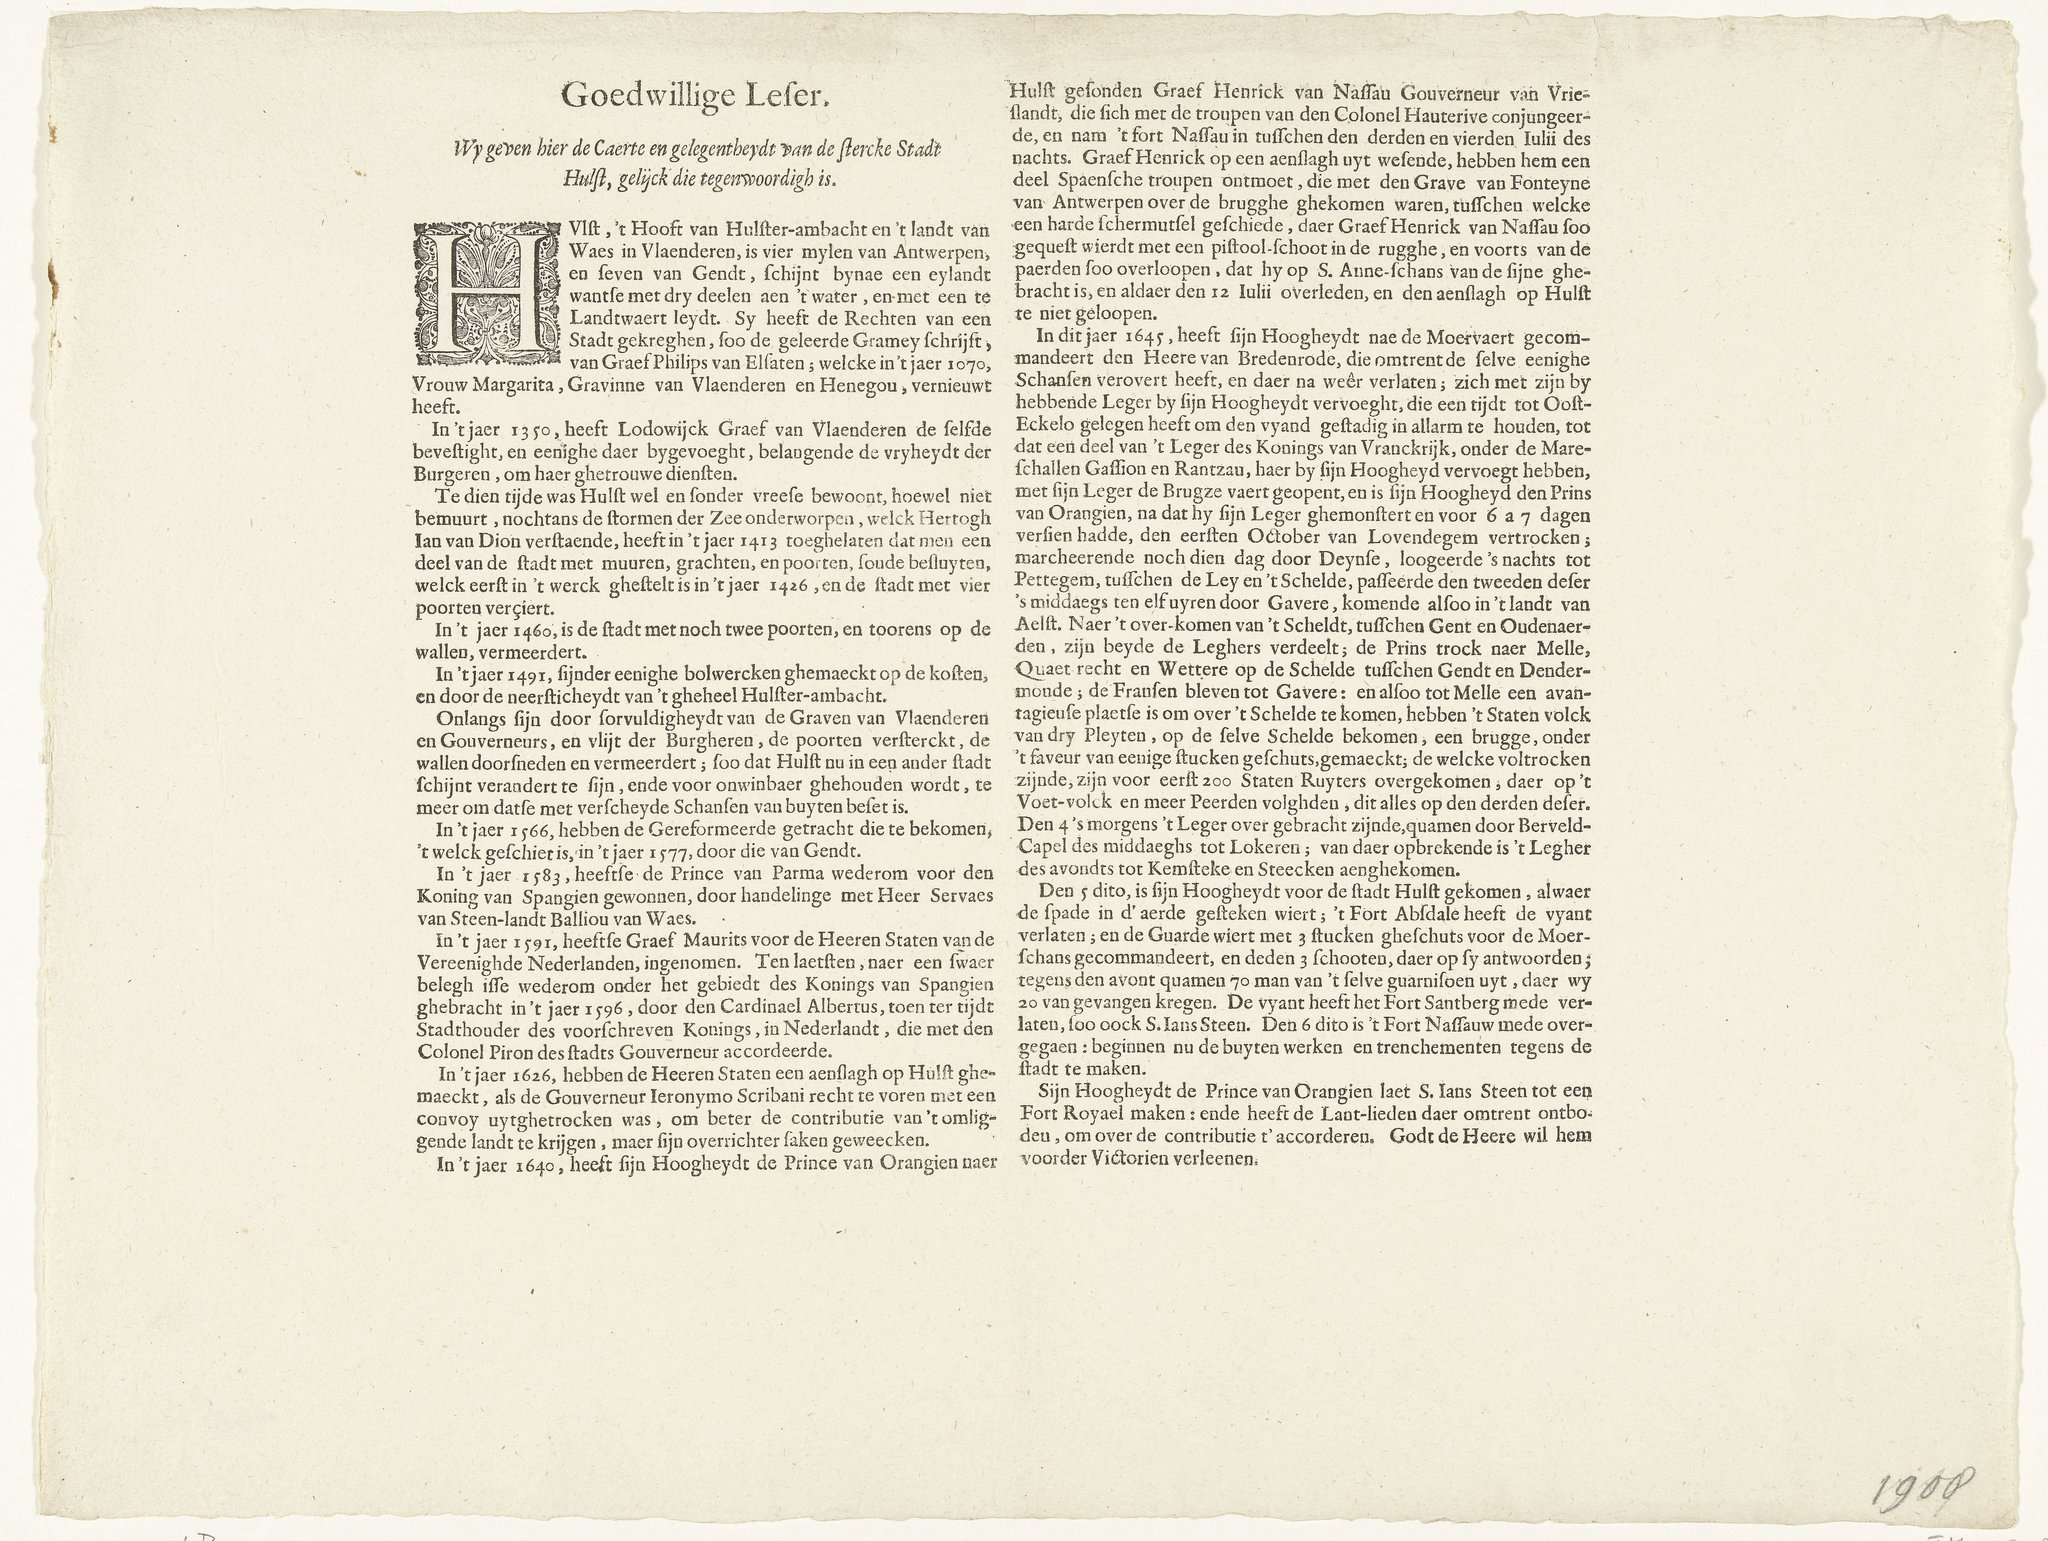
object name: print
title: Tekstblad bij het ensemble van het beleg van Hulst, 1645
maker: claes jansz. visscher (ii)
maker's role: draughtsman, print maker, publisher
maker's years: 1586-1652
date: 1645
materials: paper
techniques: letterpress printing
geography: amsterdam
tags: delft, frederick henry (prince of orange)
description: Tekstblad bij het ensemble van het beleg van Hulst, belegerd door het Staatse leger onder Frederik Hendrik van 28 september tot 5 november 1645. Blad met twee kolommen tekst in het Nederlands, bovenaan een aanhef gericht aan de 'Goedwillige Leser'. Wellicht onderdeel van een ongemonteerd ensemble bestaande uit de twee kaarten, het profiel, het blad met de zes forten, de drie bladen van de uittocht van het garnizoen en de twee tekstbladen.